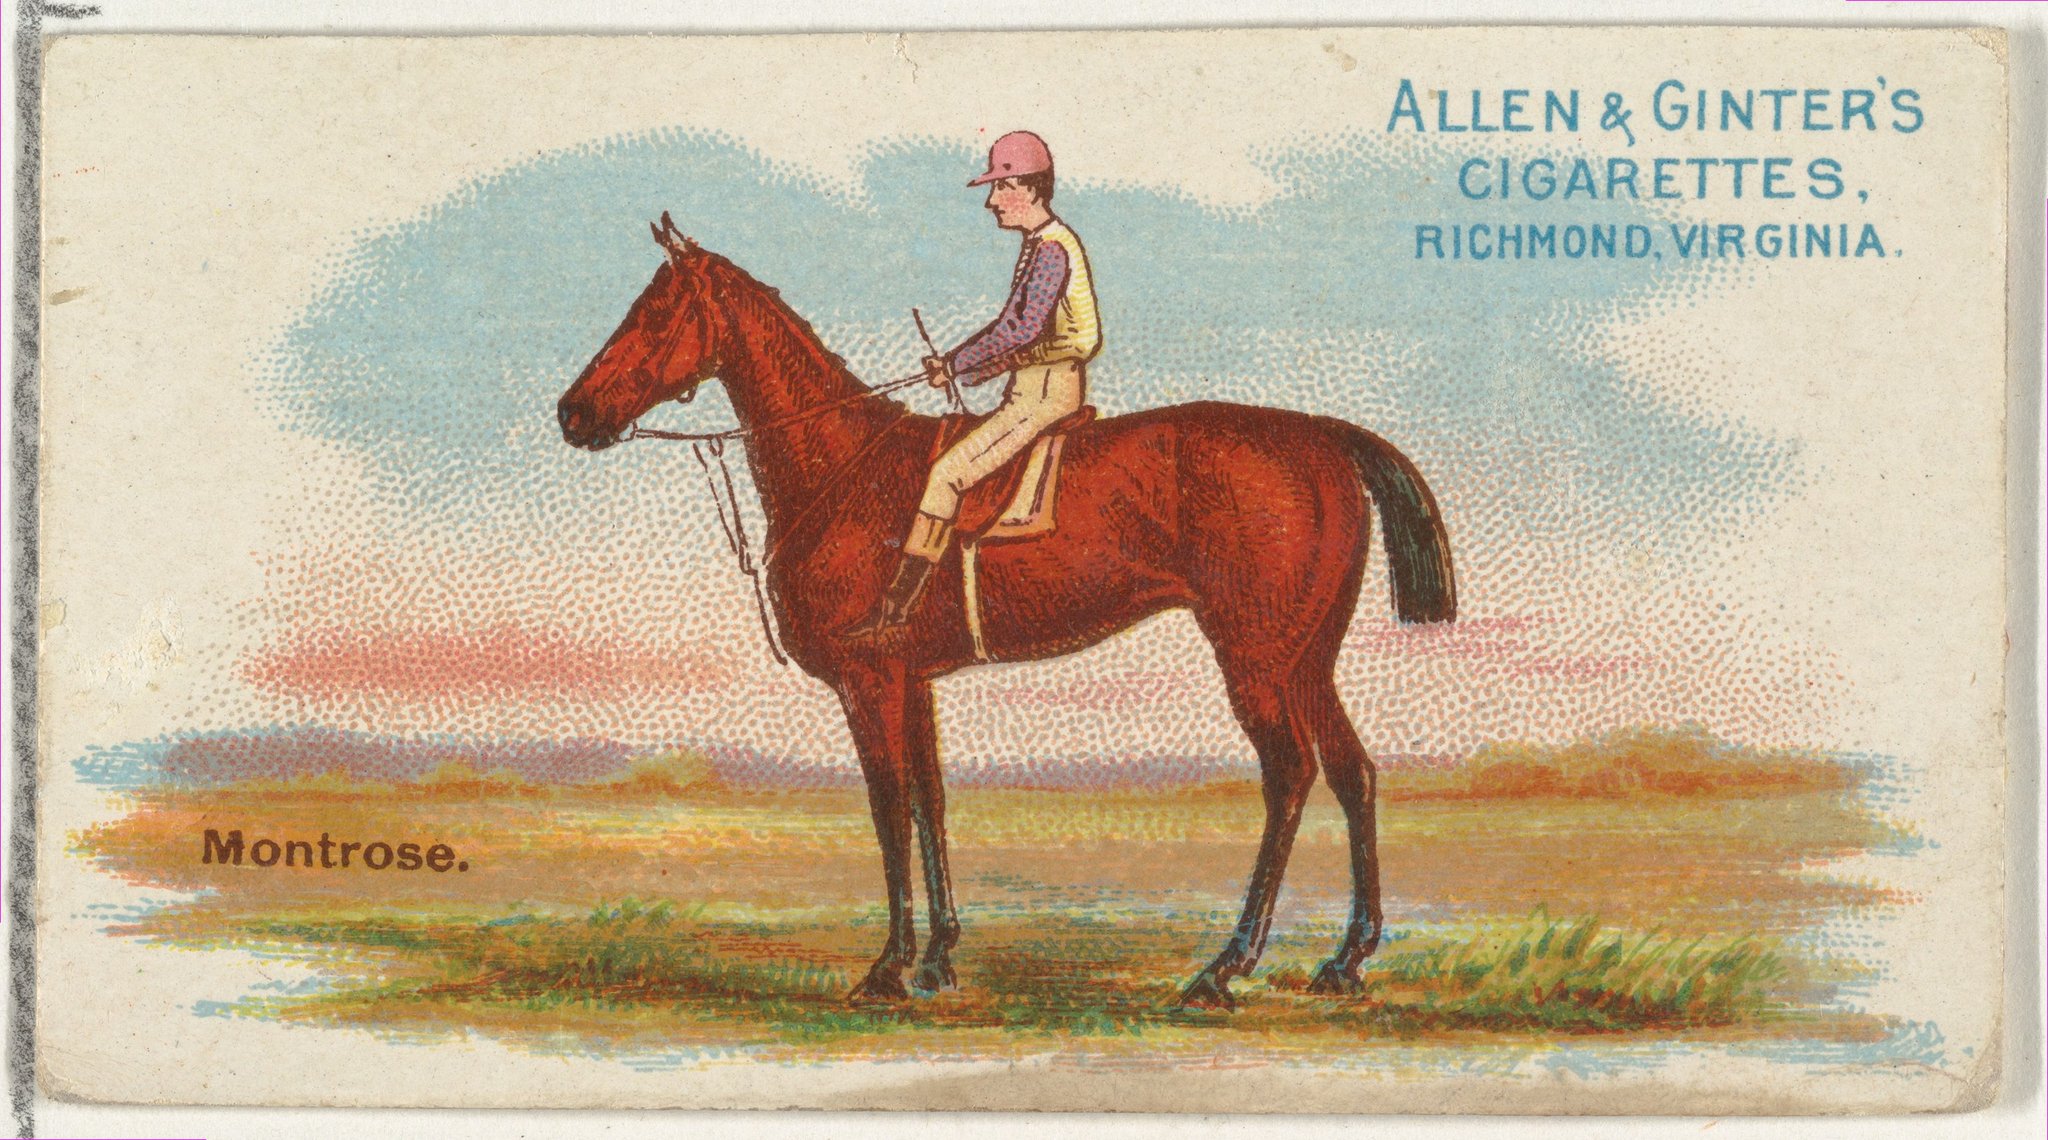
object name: print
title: Montrose, from The World's Racers series (N32) for Allen & Ginter Cigarettes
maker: allen & ginter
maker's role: publisher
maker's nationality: american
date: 1888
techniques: color lithograph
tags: men,horses,jockeys